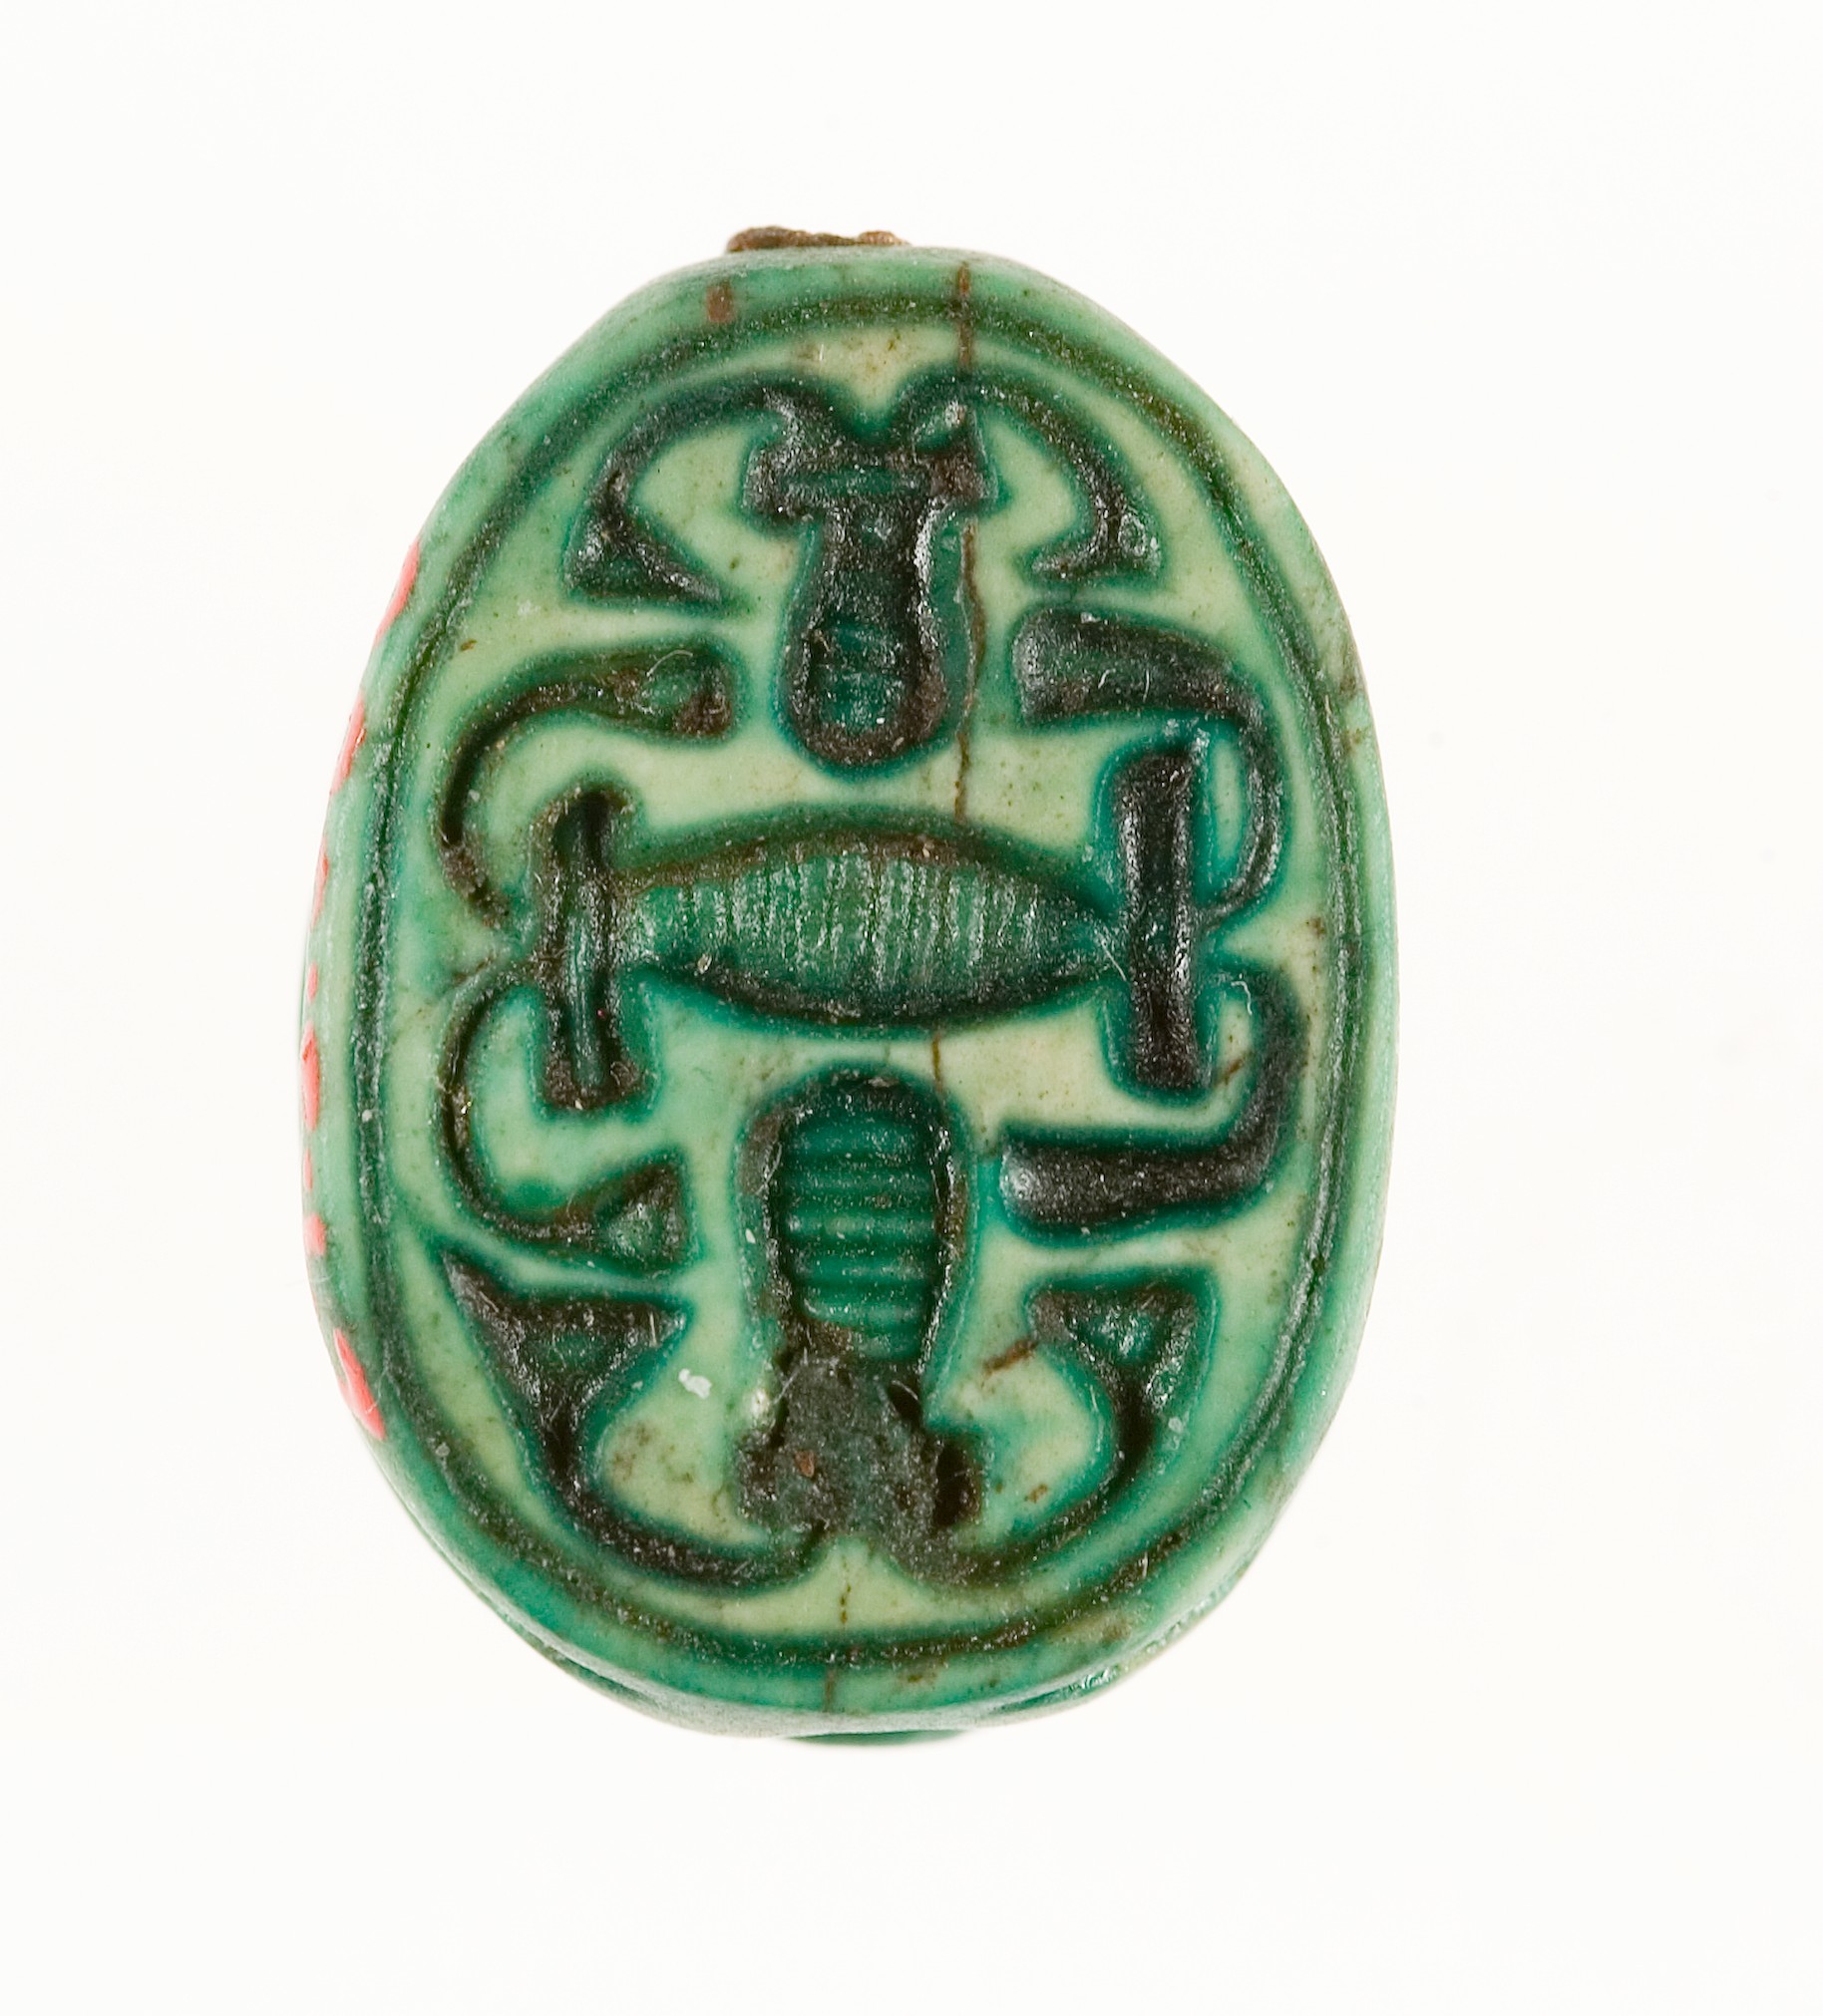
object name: scarab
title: Scarab Inscribed with a Geometric Pattern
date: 1479-1458 BCE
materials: stone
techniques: glazing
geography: egypt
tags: scarabs